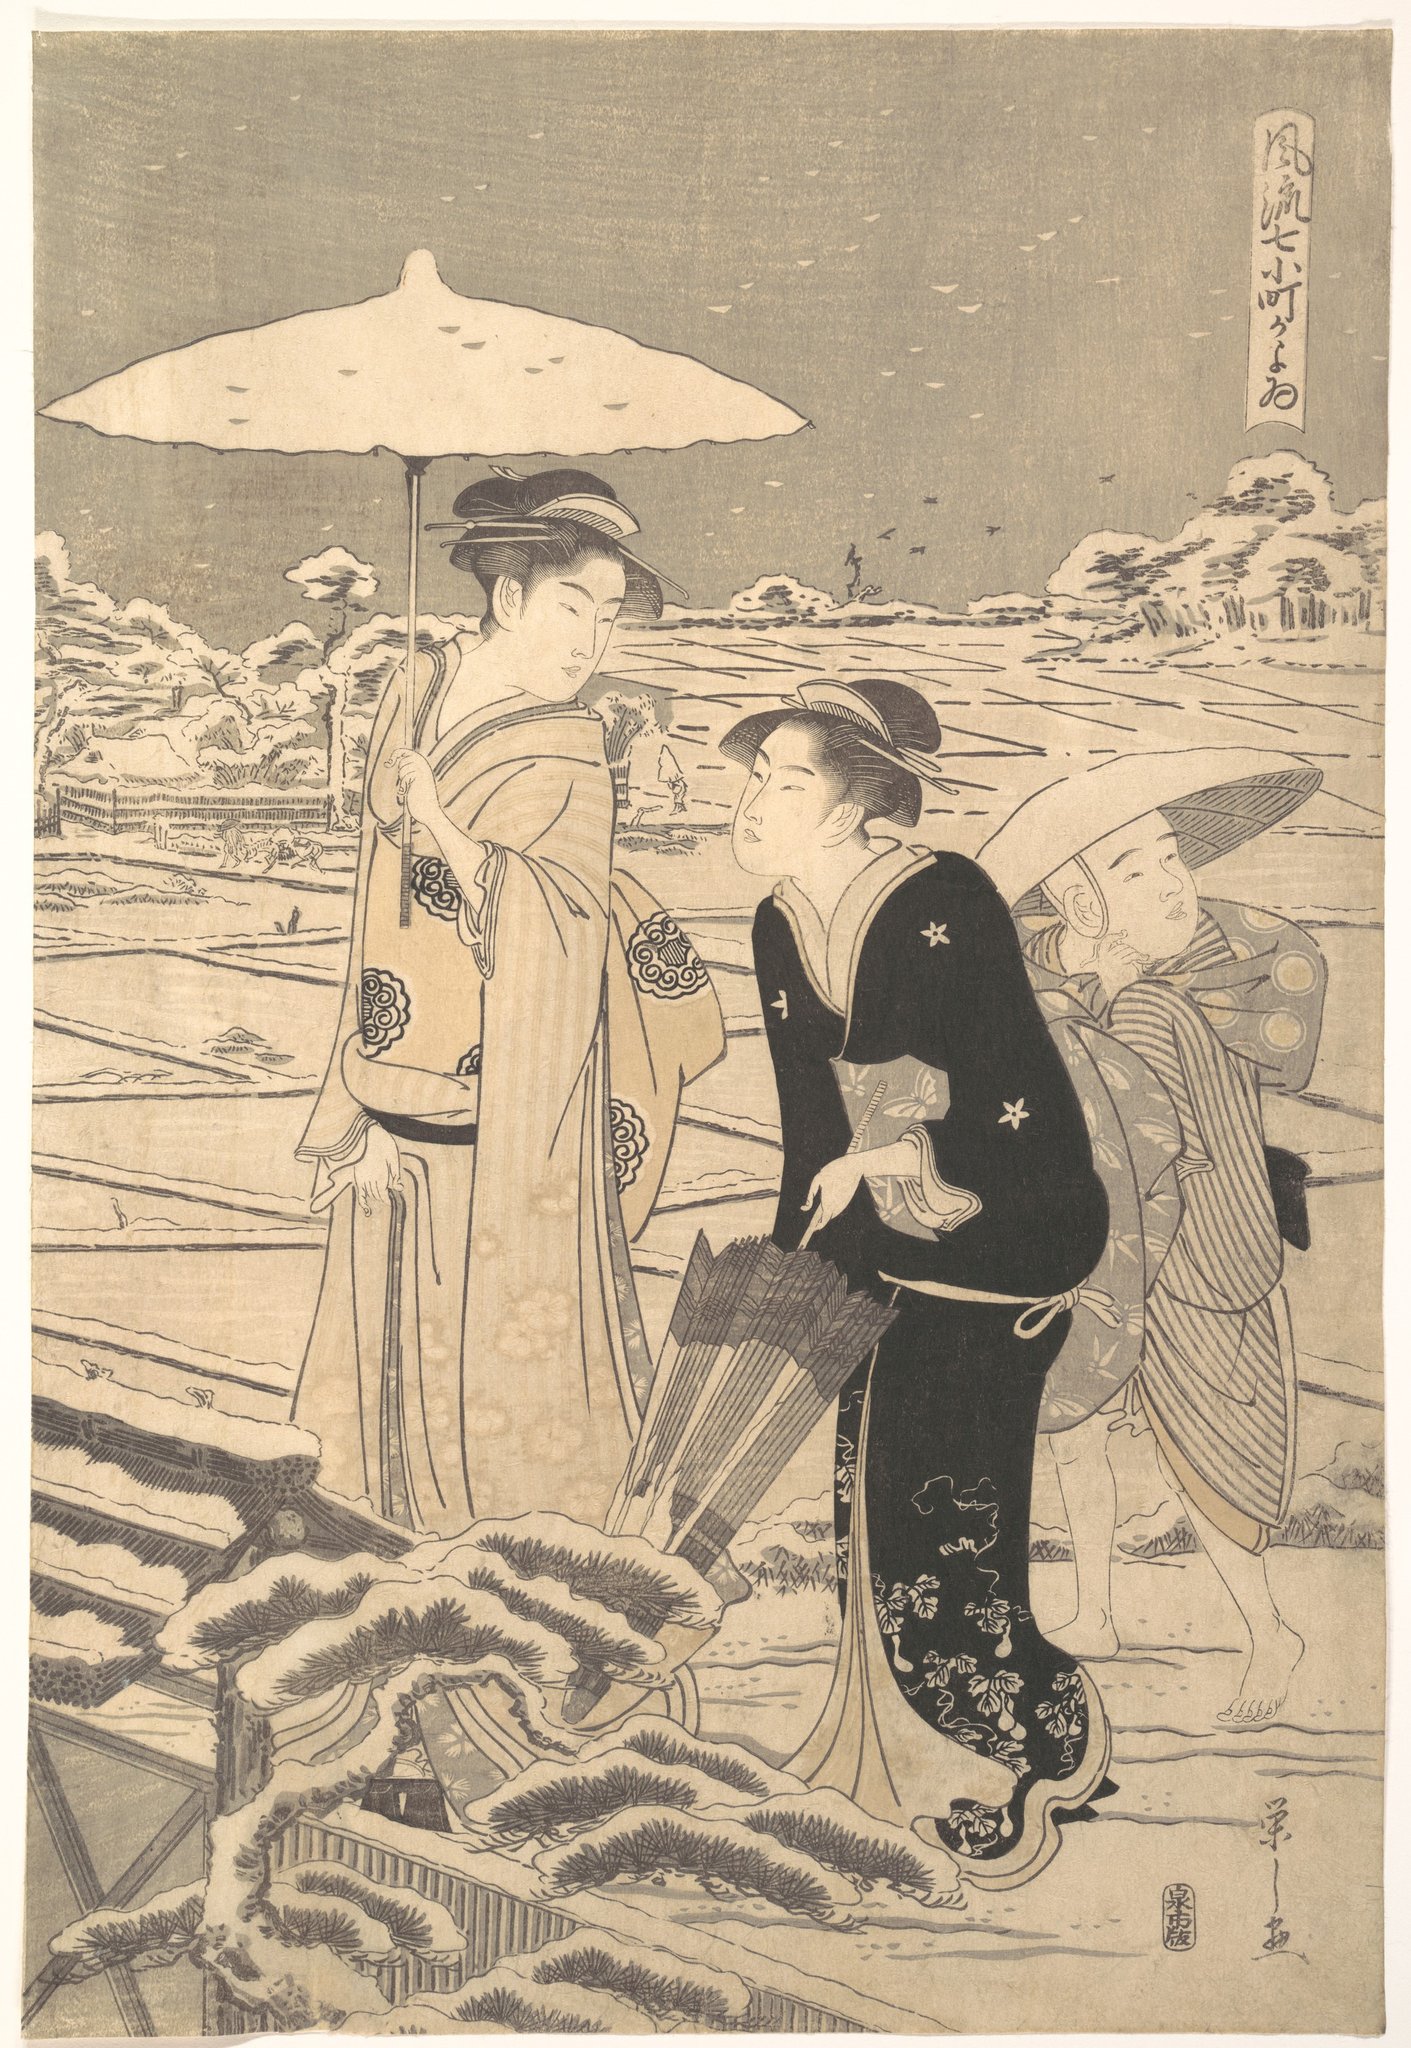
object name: print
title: Kayoi Komachi, from the series "Seven Elegant Episodes of the Poet Komachi" (Fūryū nanakomachi kayoi)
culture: japanese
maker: chōbunsai eishi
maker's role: artist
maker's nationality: japanese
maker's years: 1756-1829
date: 1795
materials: ink, paper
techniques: woodblock print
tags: women,plants,actors